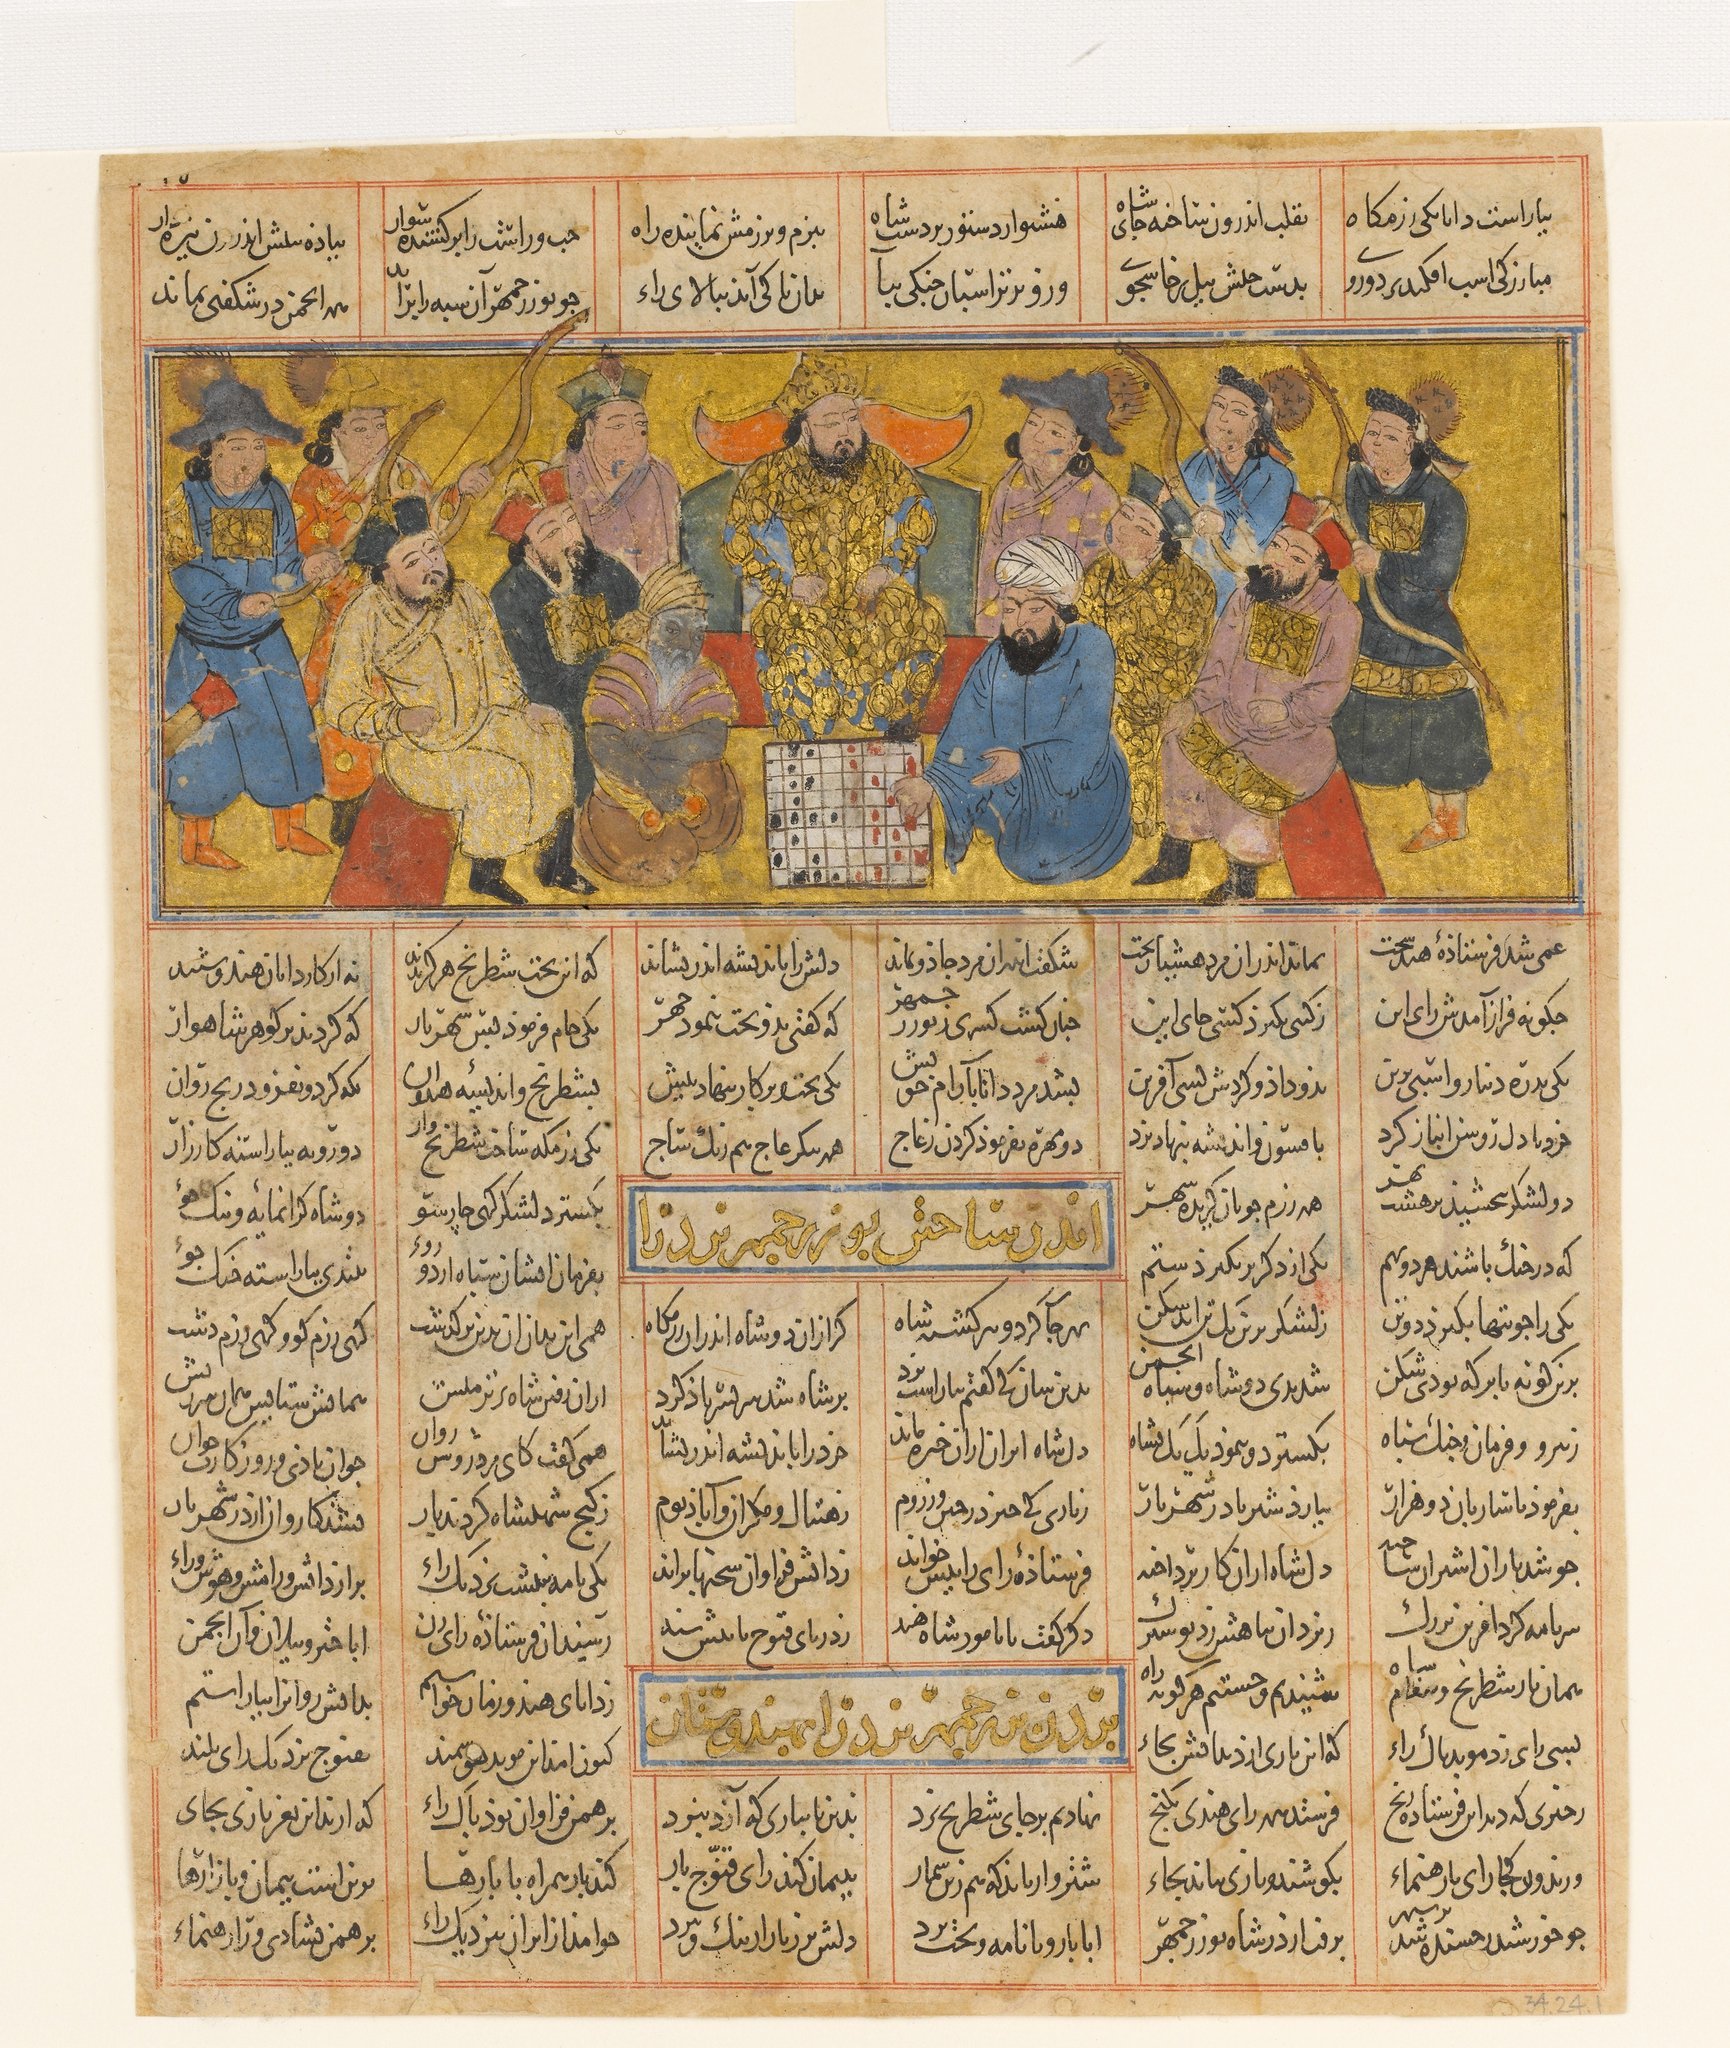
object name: folio from an illustrated manuscript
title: "Buzurgmihr Masters the Game of Chess", Folio from the First Small Shahnama (Book of Kings)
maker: abu'l qasim firdausi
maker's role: author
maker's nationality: iranian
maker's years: 935-1020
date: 1300-1330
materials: gold, ink, paper, watercolor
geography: iran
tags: bow and arrow,men,chess,games